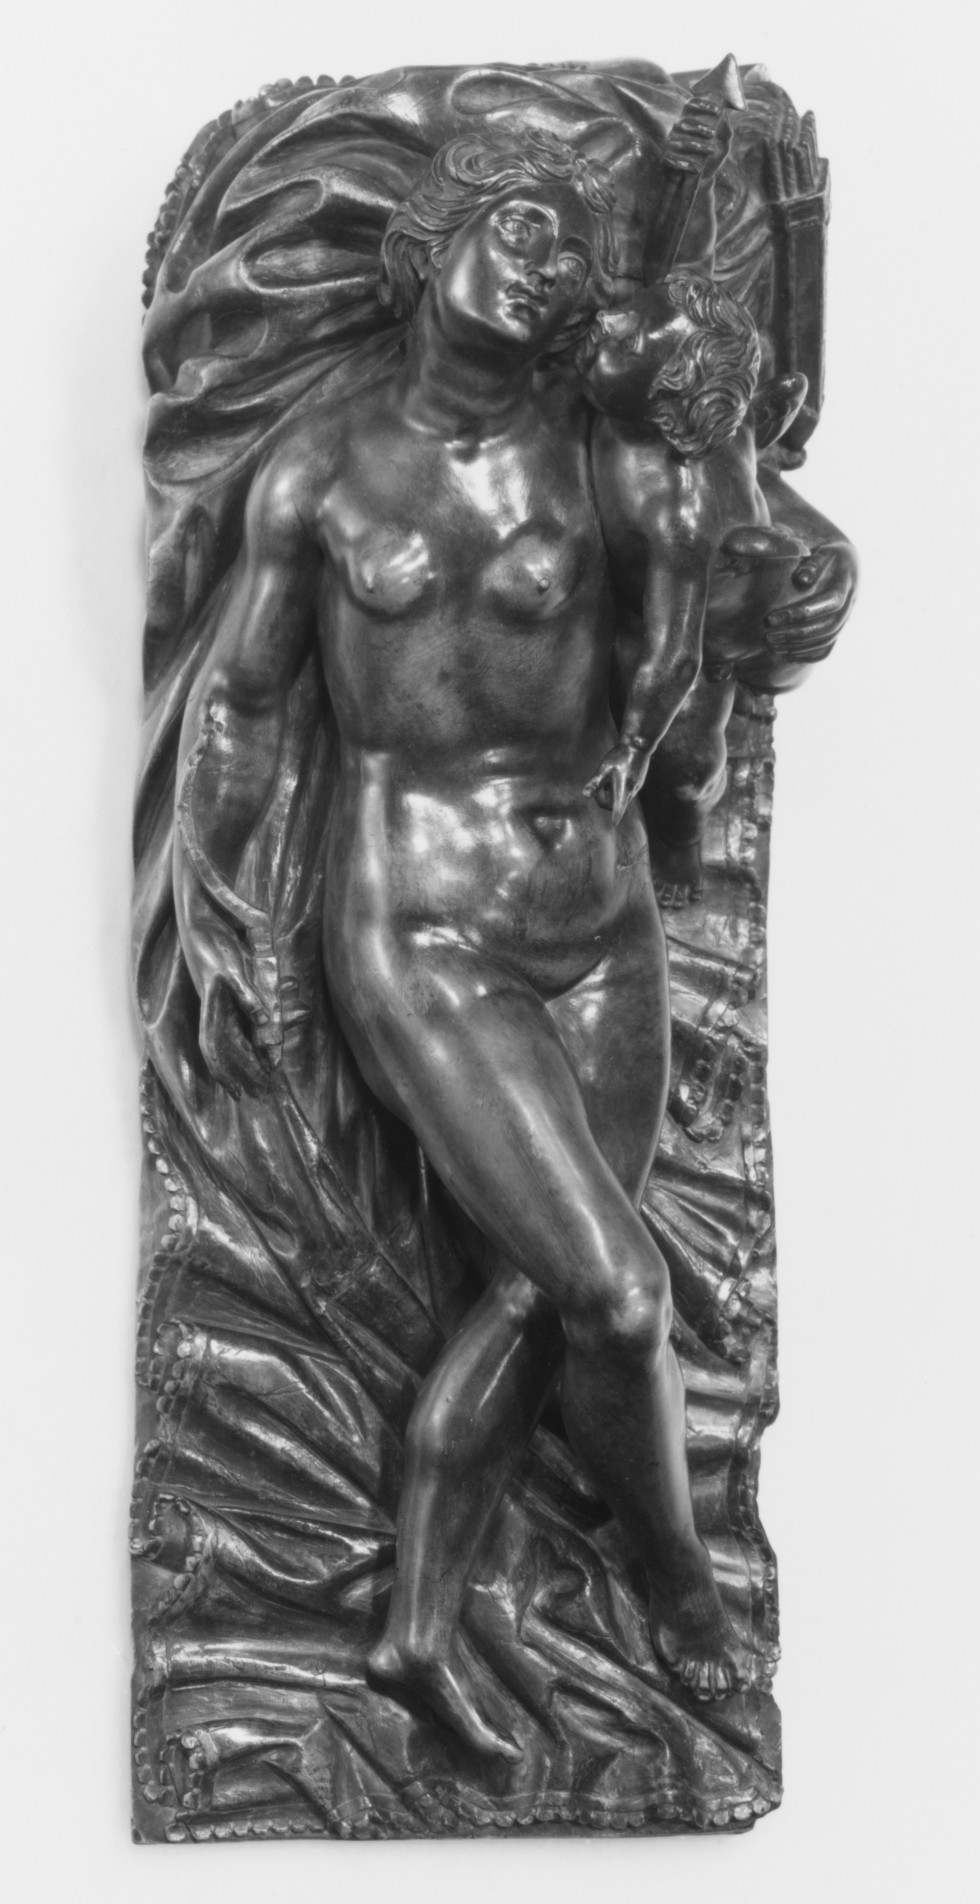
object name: sculpture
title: Venus Disarming Cupid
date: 1634-1666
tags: cupid,venus